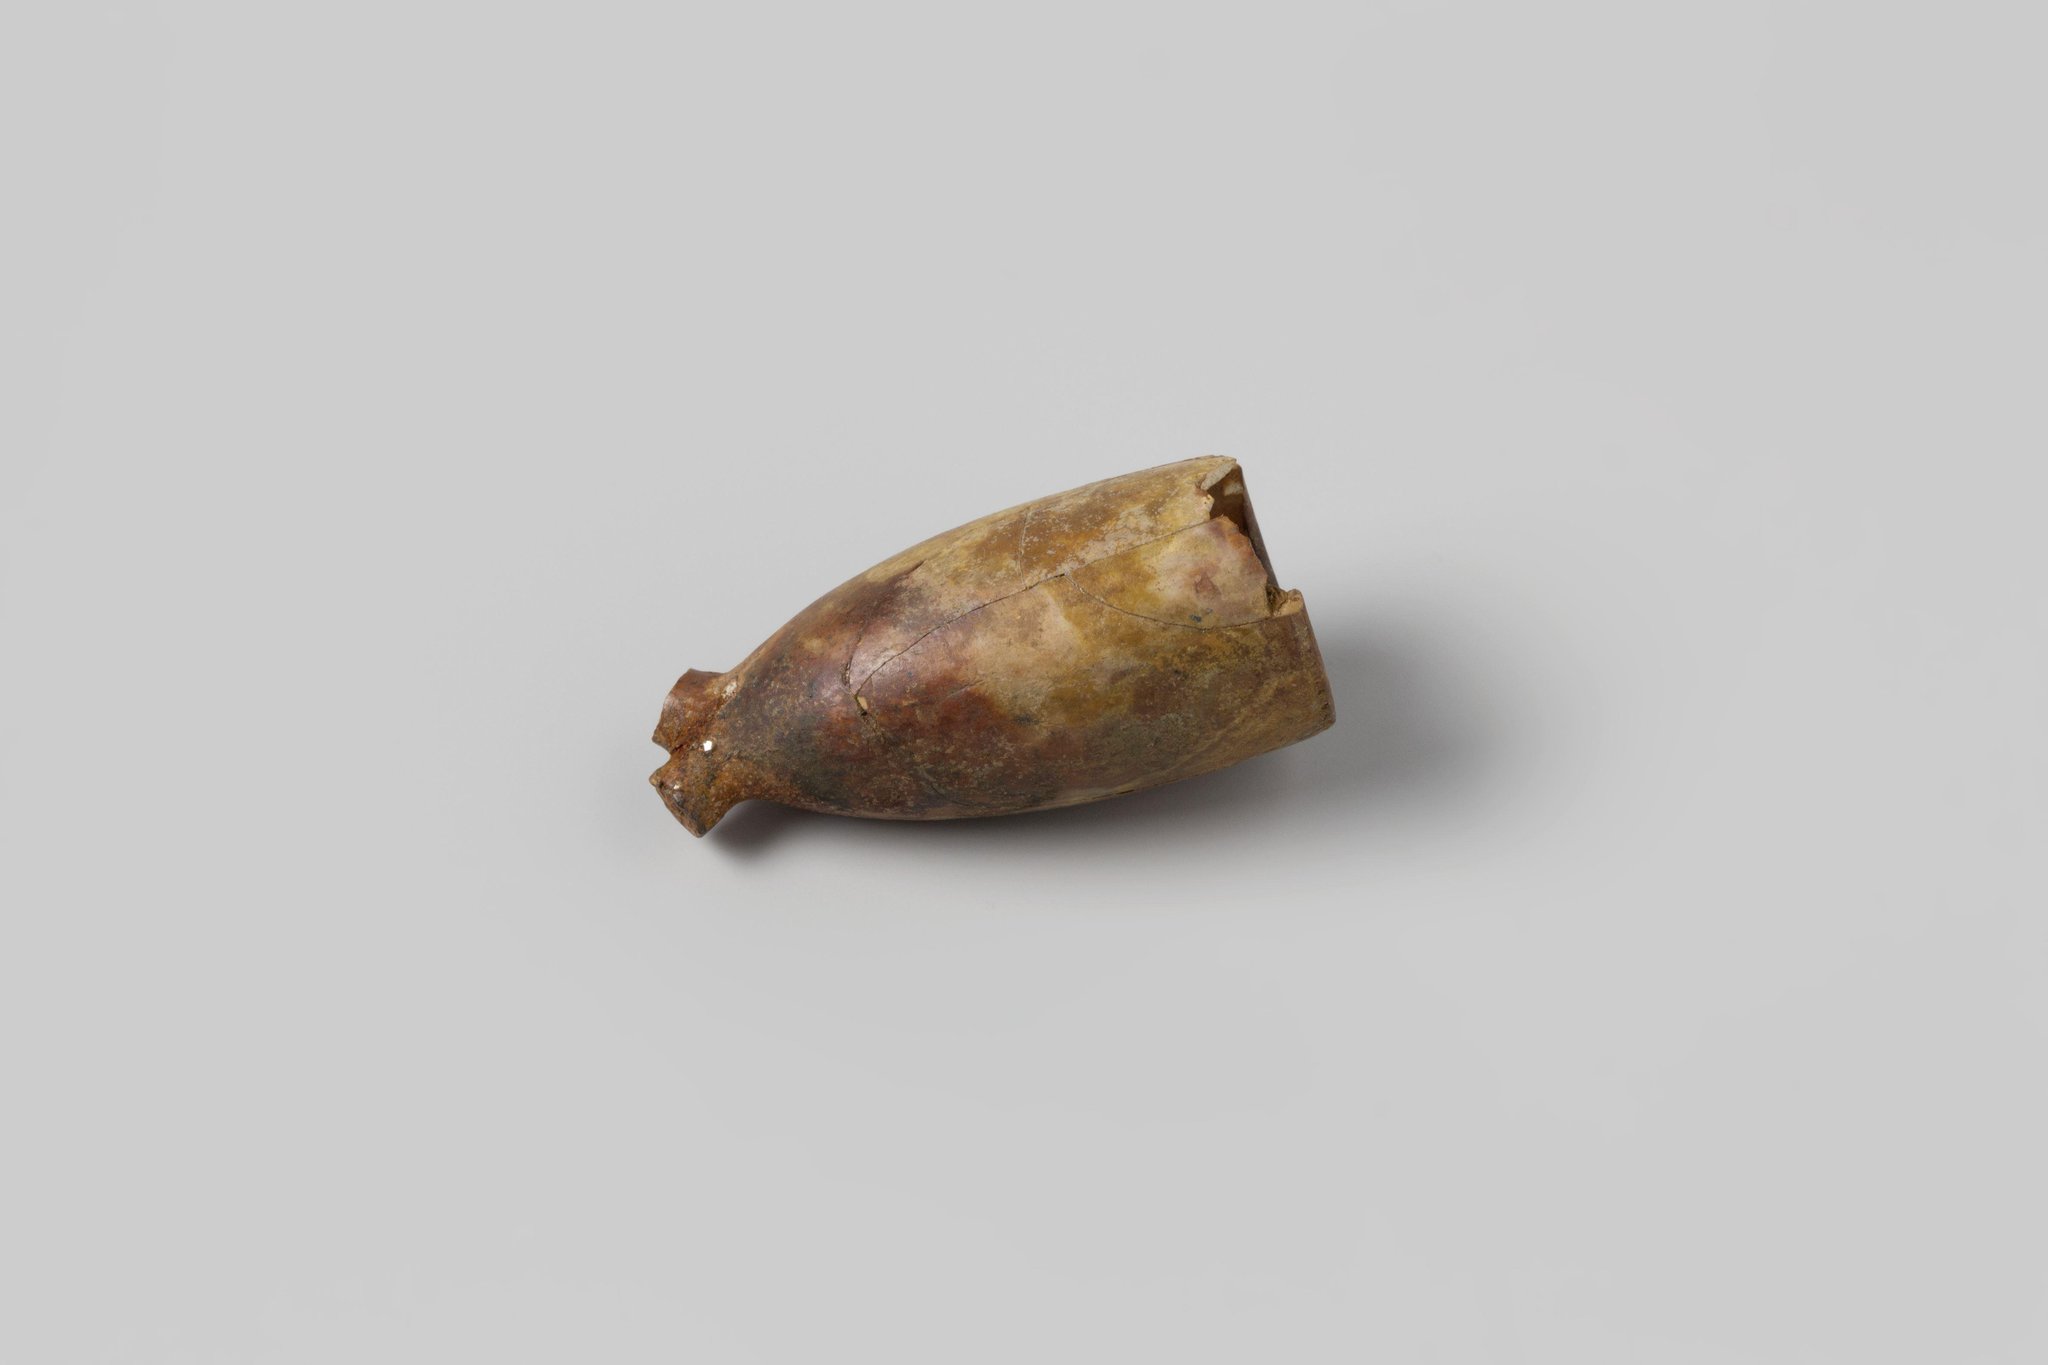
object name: pipe bowl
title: Pijpenkop uit het wrak van de Oost-Indiëvaarder Hollandia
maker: Anonymous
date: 1700-1743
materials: clay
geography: netherlands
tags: verenigde oostindische compagnie, hollandia (schip), annet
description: Pipe, bowl, heelmark: crowned 91; fragment, 1hsm1.